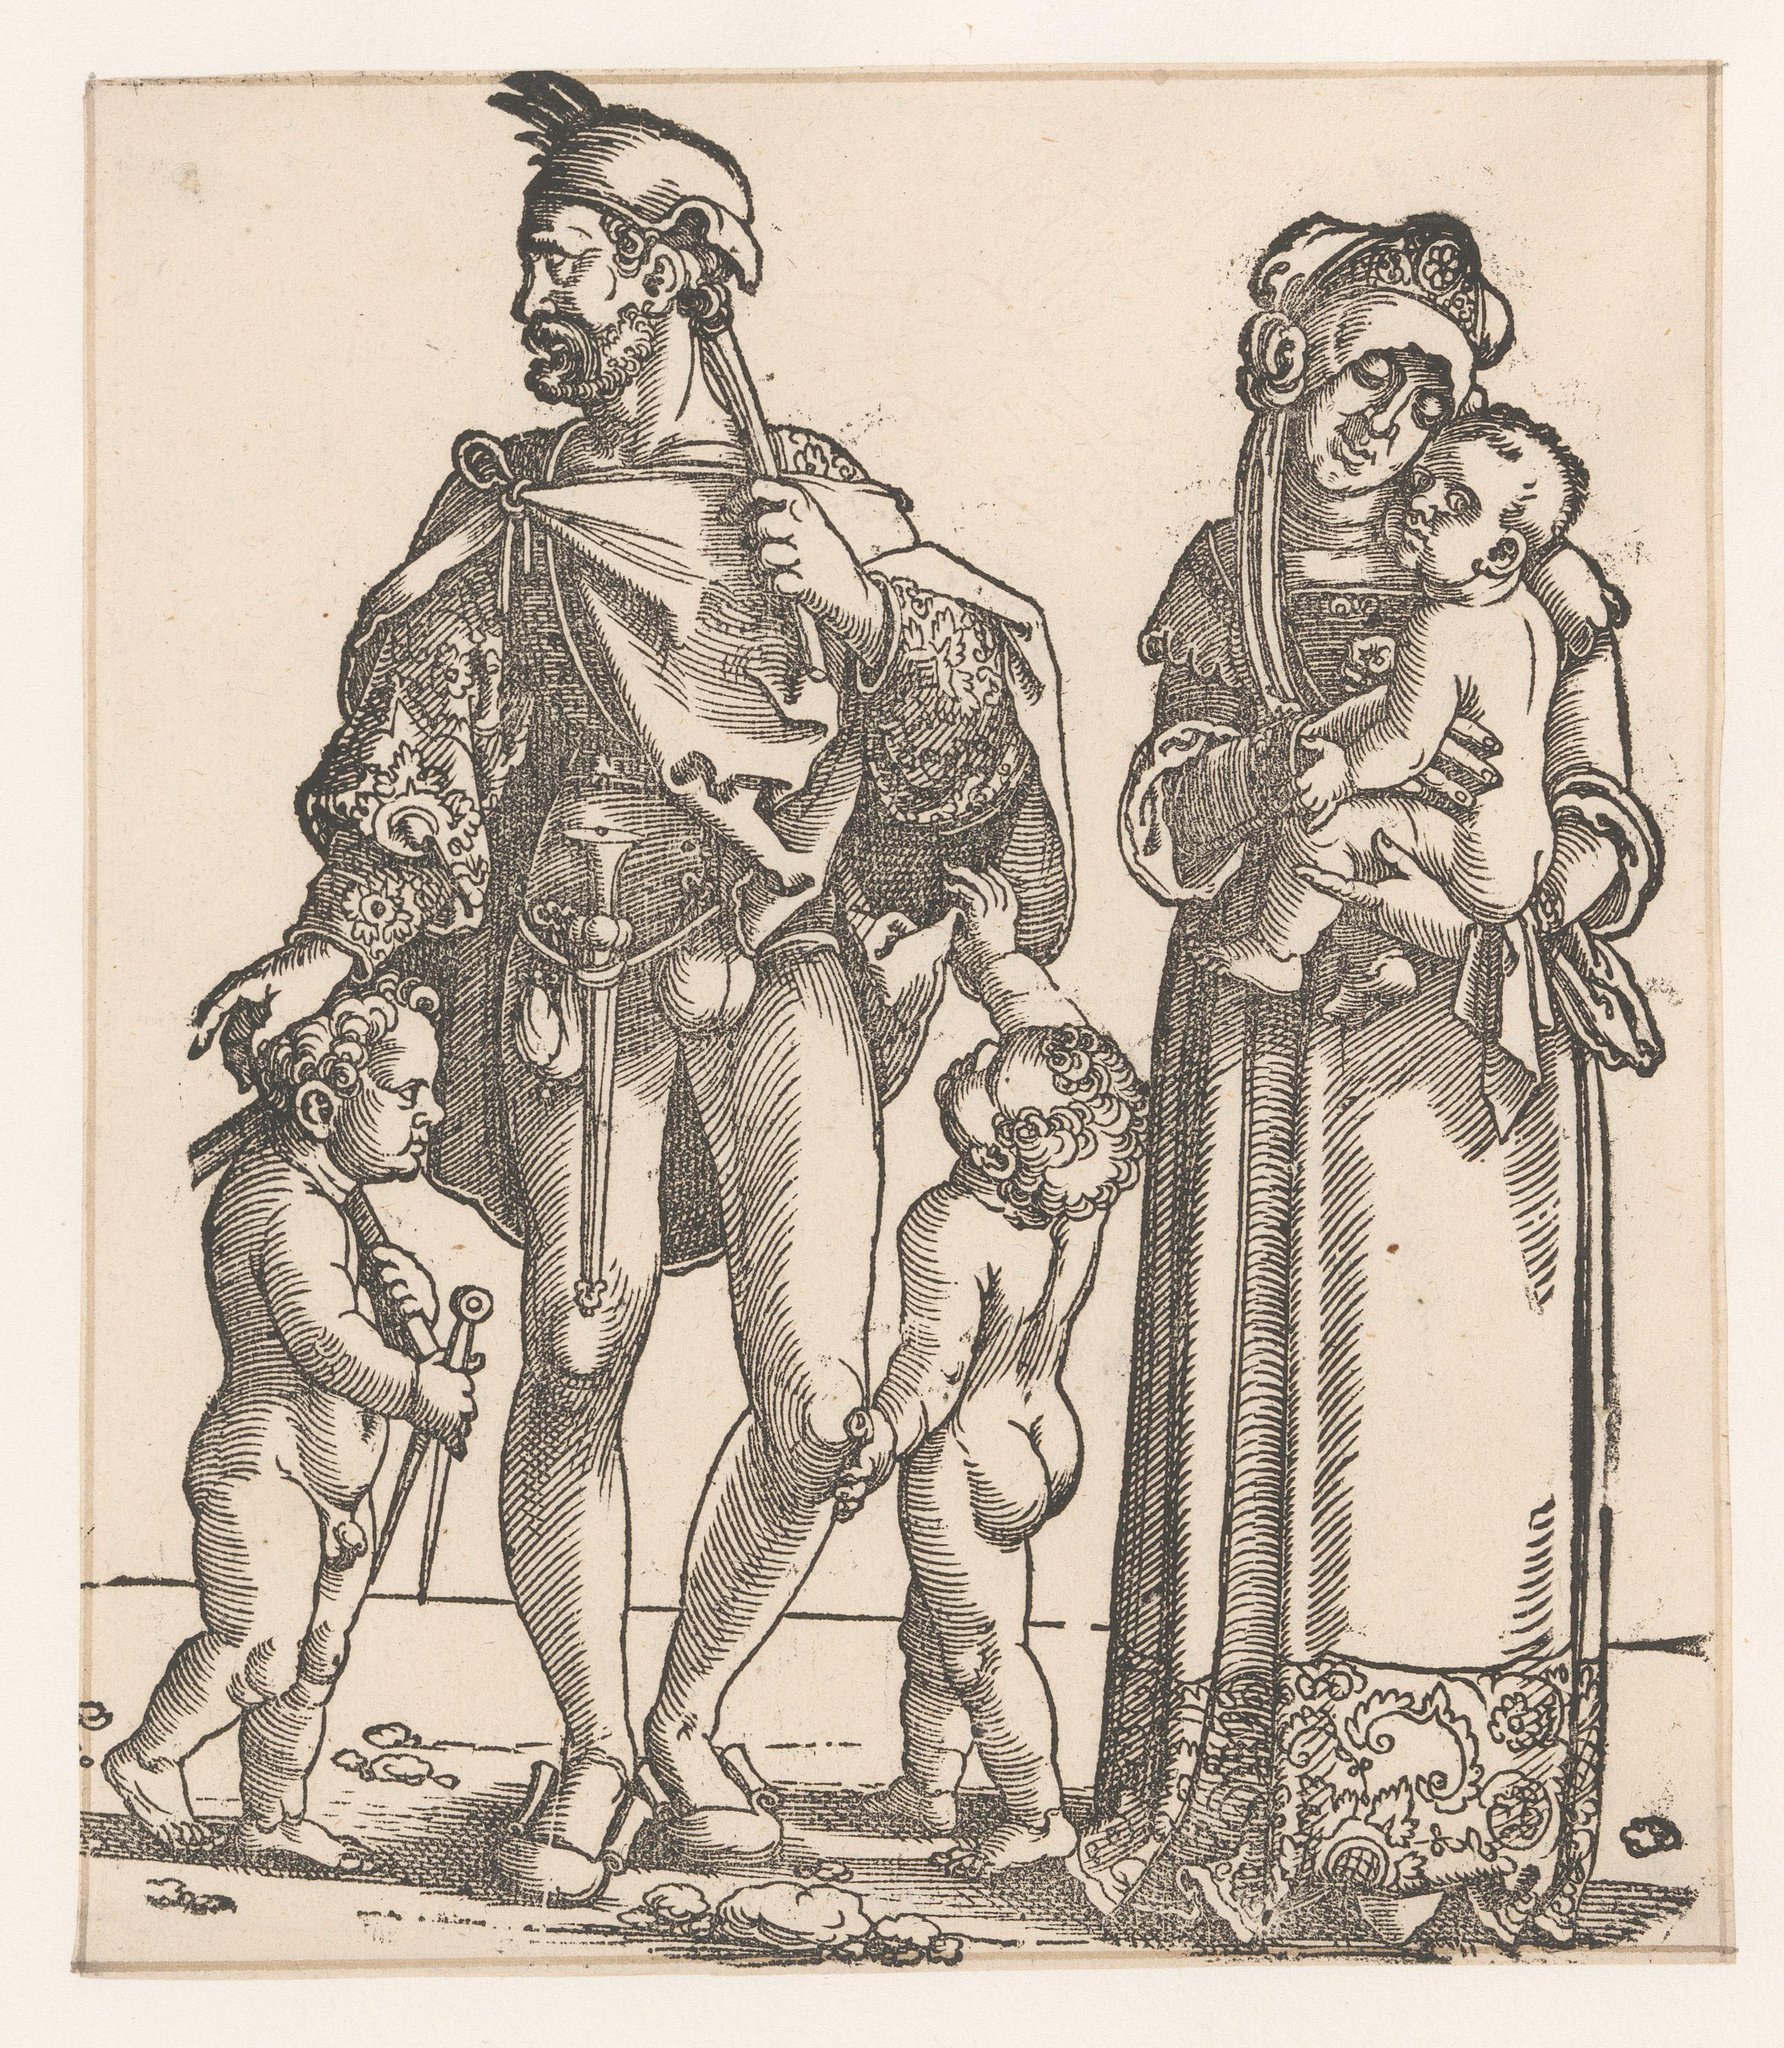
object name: print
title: Jered met zijn vrouw en kinderen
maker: Anonymous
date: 1530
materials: paper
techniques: woodcut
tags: male persons from the old testament (jered) (jered)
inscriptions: collector's mark: Lugt 240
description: Onderdeel van een serie van tien houtsnedes met de patriarchen.